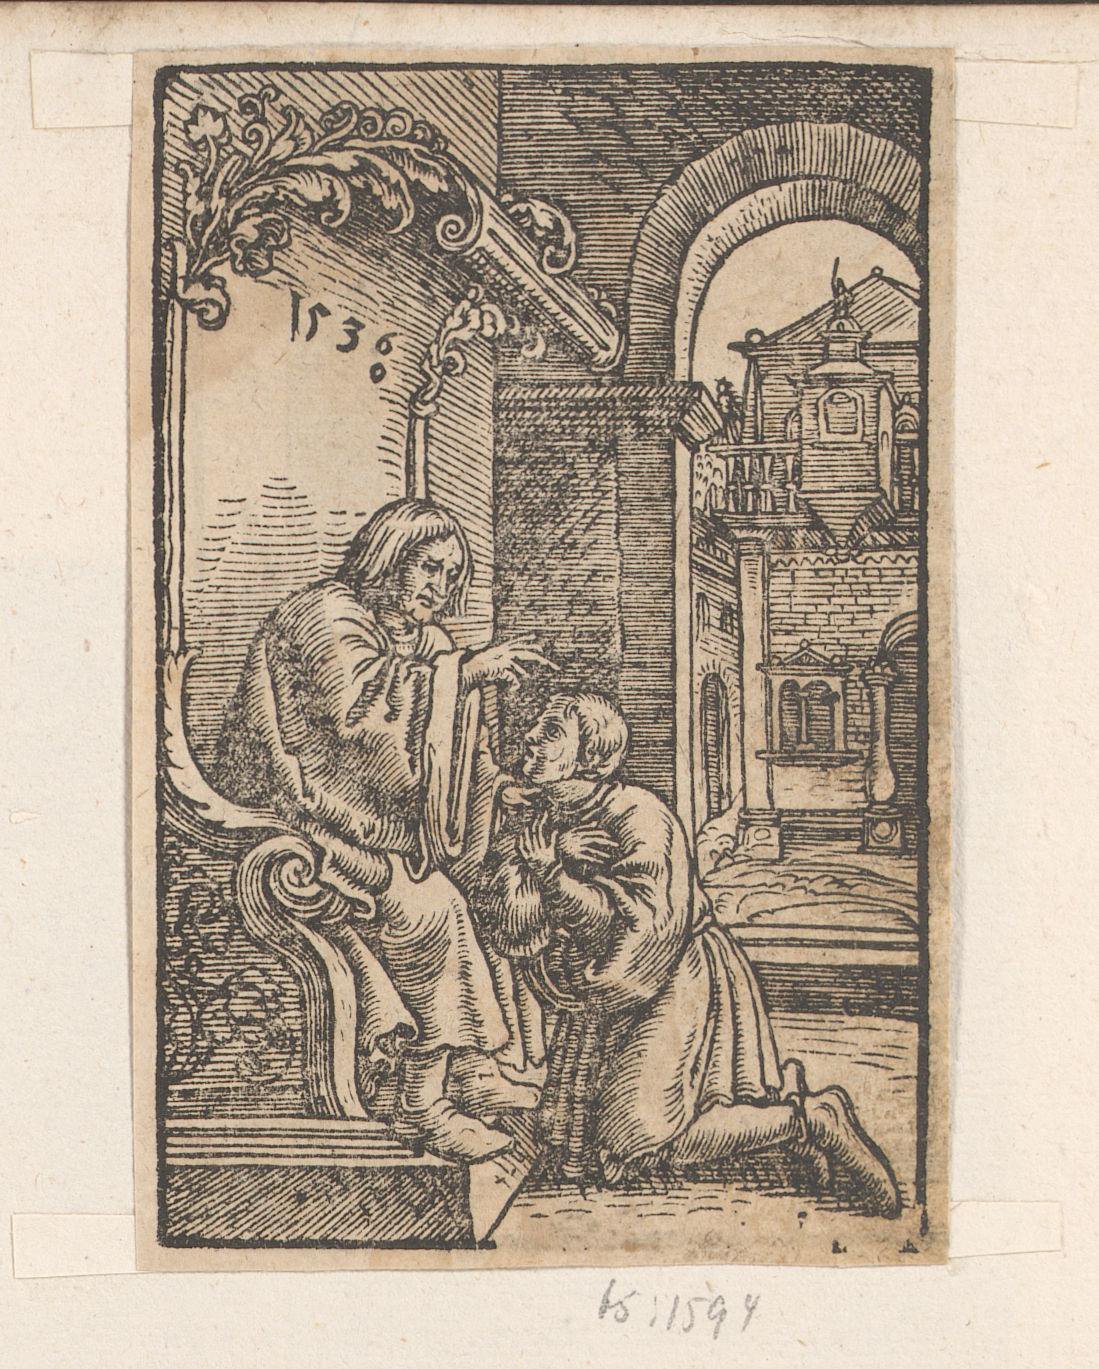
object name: print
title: Vorst zegent zijn zoon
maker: anton von woensam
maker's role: print maker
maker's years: 1500-1541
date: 1536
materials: paper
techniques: woodcut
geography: germany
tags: laying on hands ~ jewish religion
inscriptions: date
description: Een vorst op een troon zegent een man, wellicht zijn zoon. Prent maakt deel uit van een album.